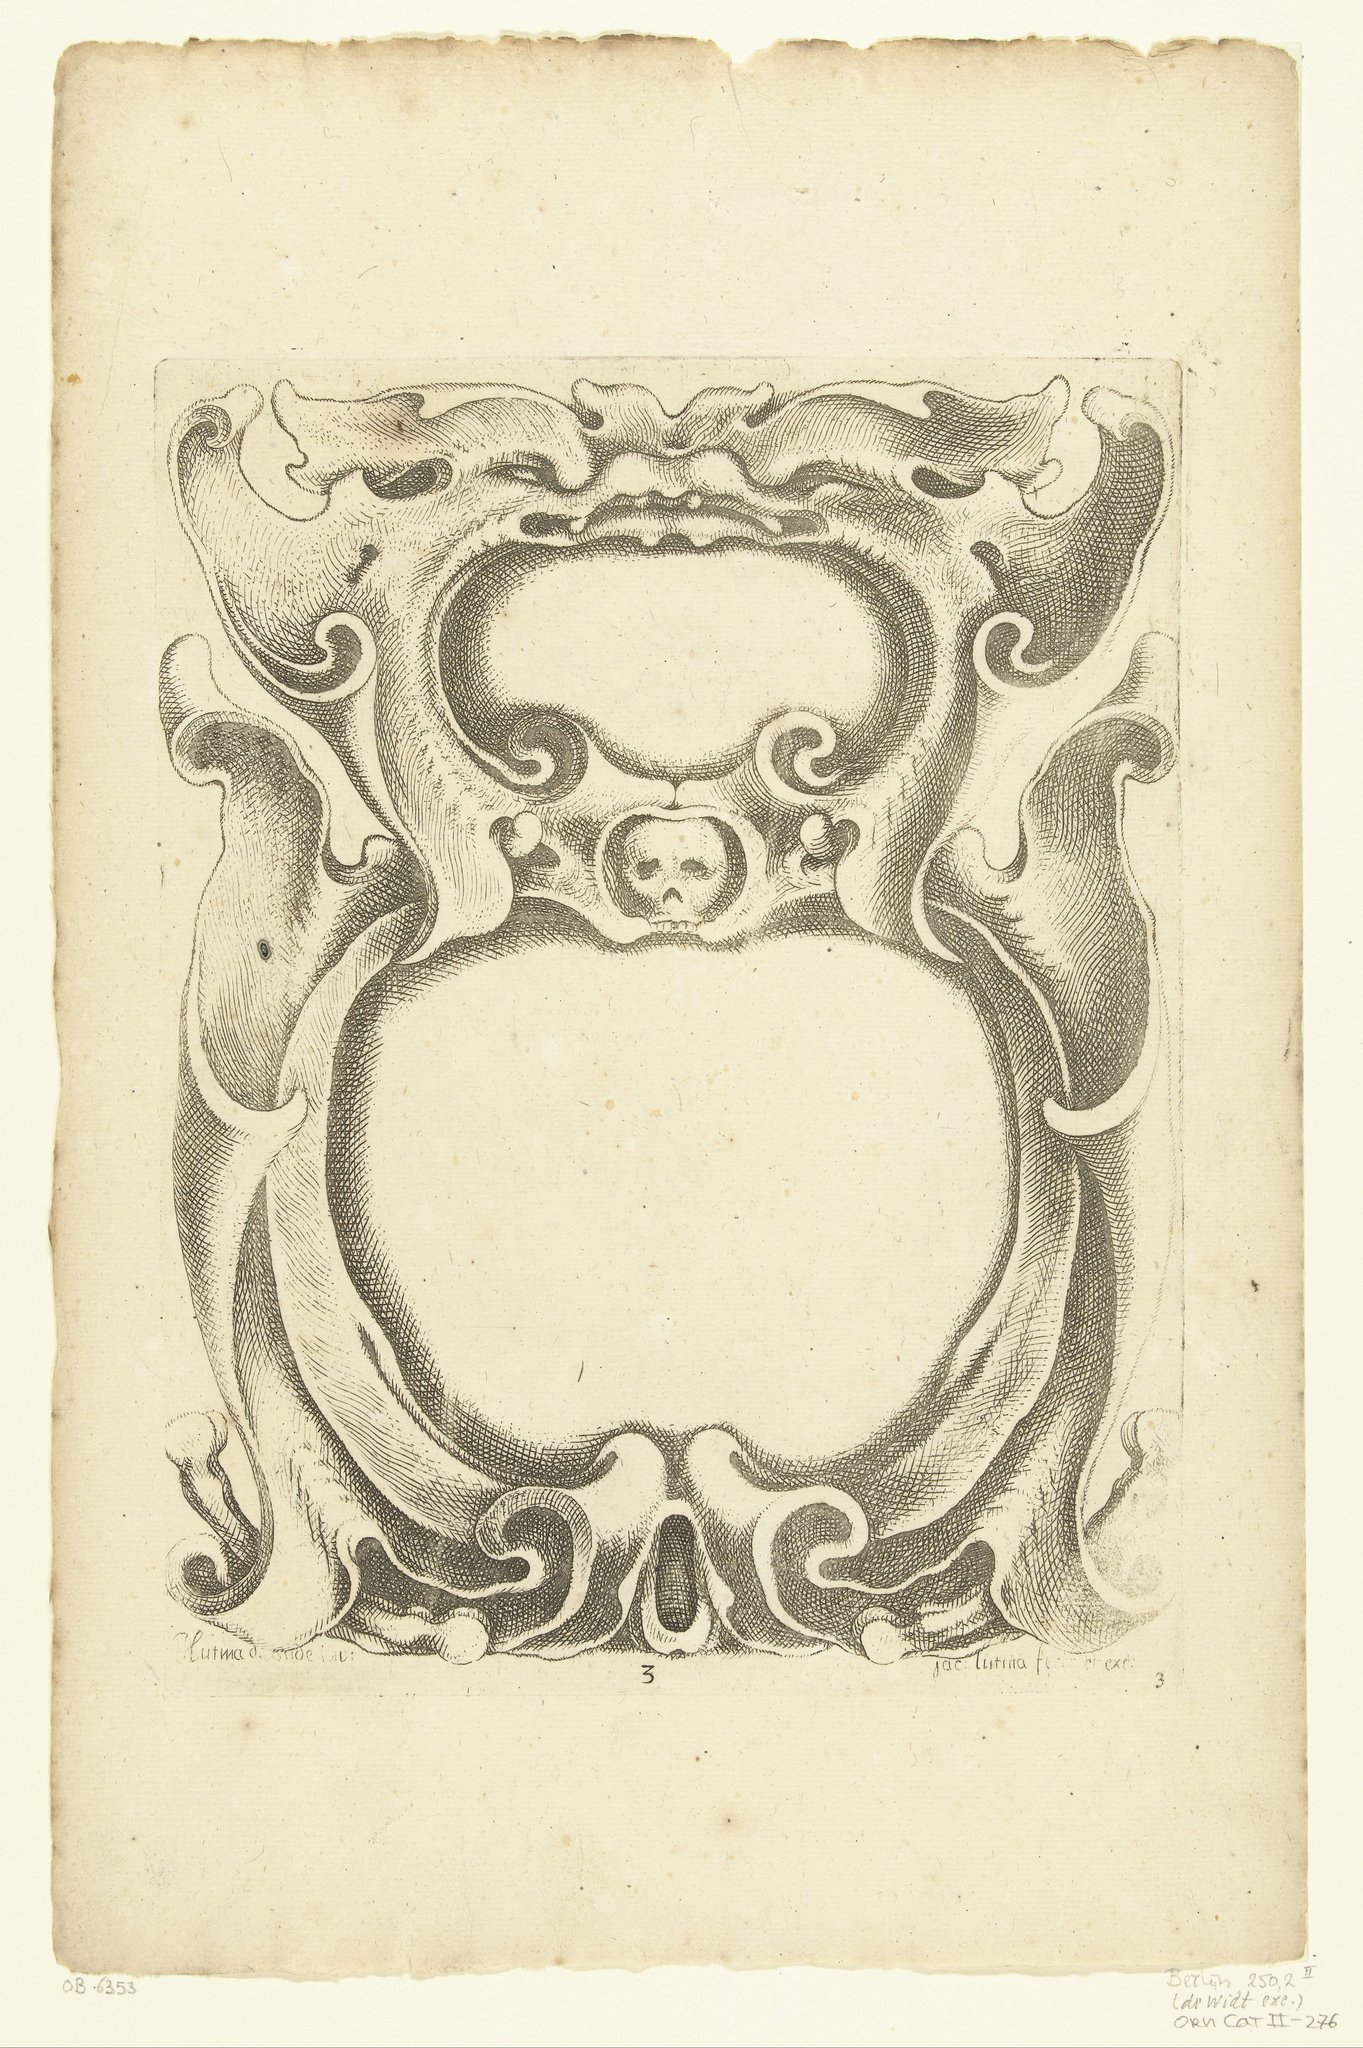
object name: print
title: Cartouche met schedel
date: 1654-1678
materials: paper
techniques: etching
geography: amsterdam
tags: (human) skull, ornament ~ cartouche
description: Cartouche met twee compartimenten, de bovenste in een masker, met ertussenin een schedel. Prent uit tweede editie van serie.